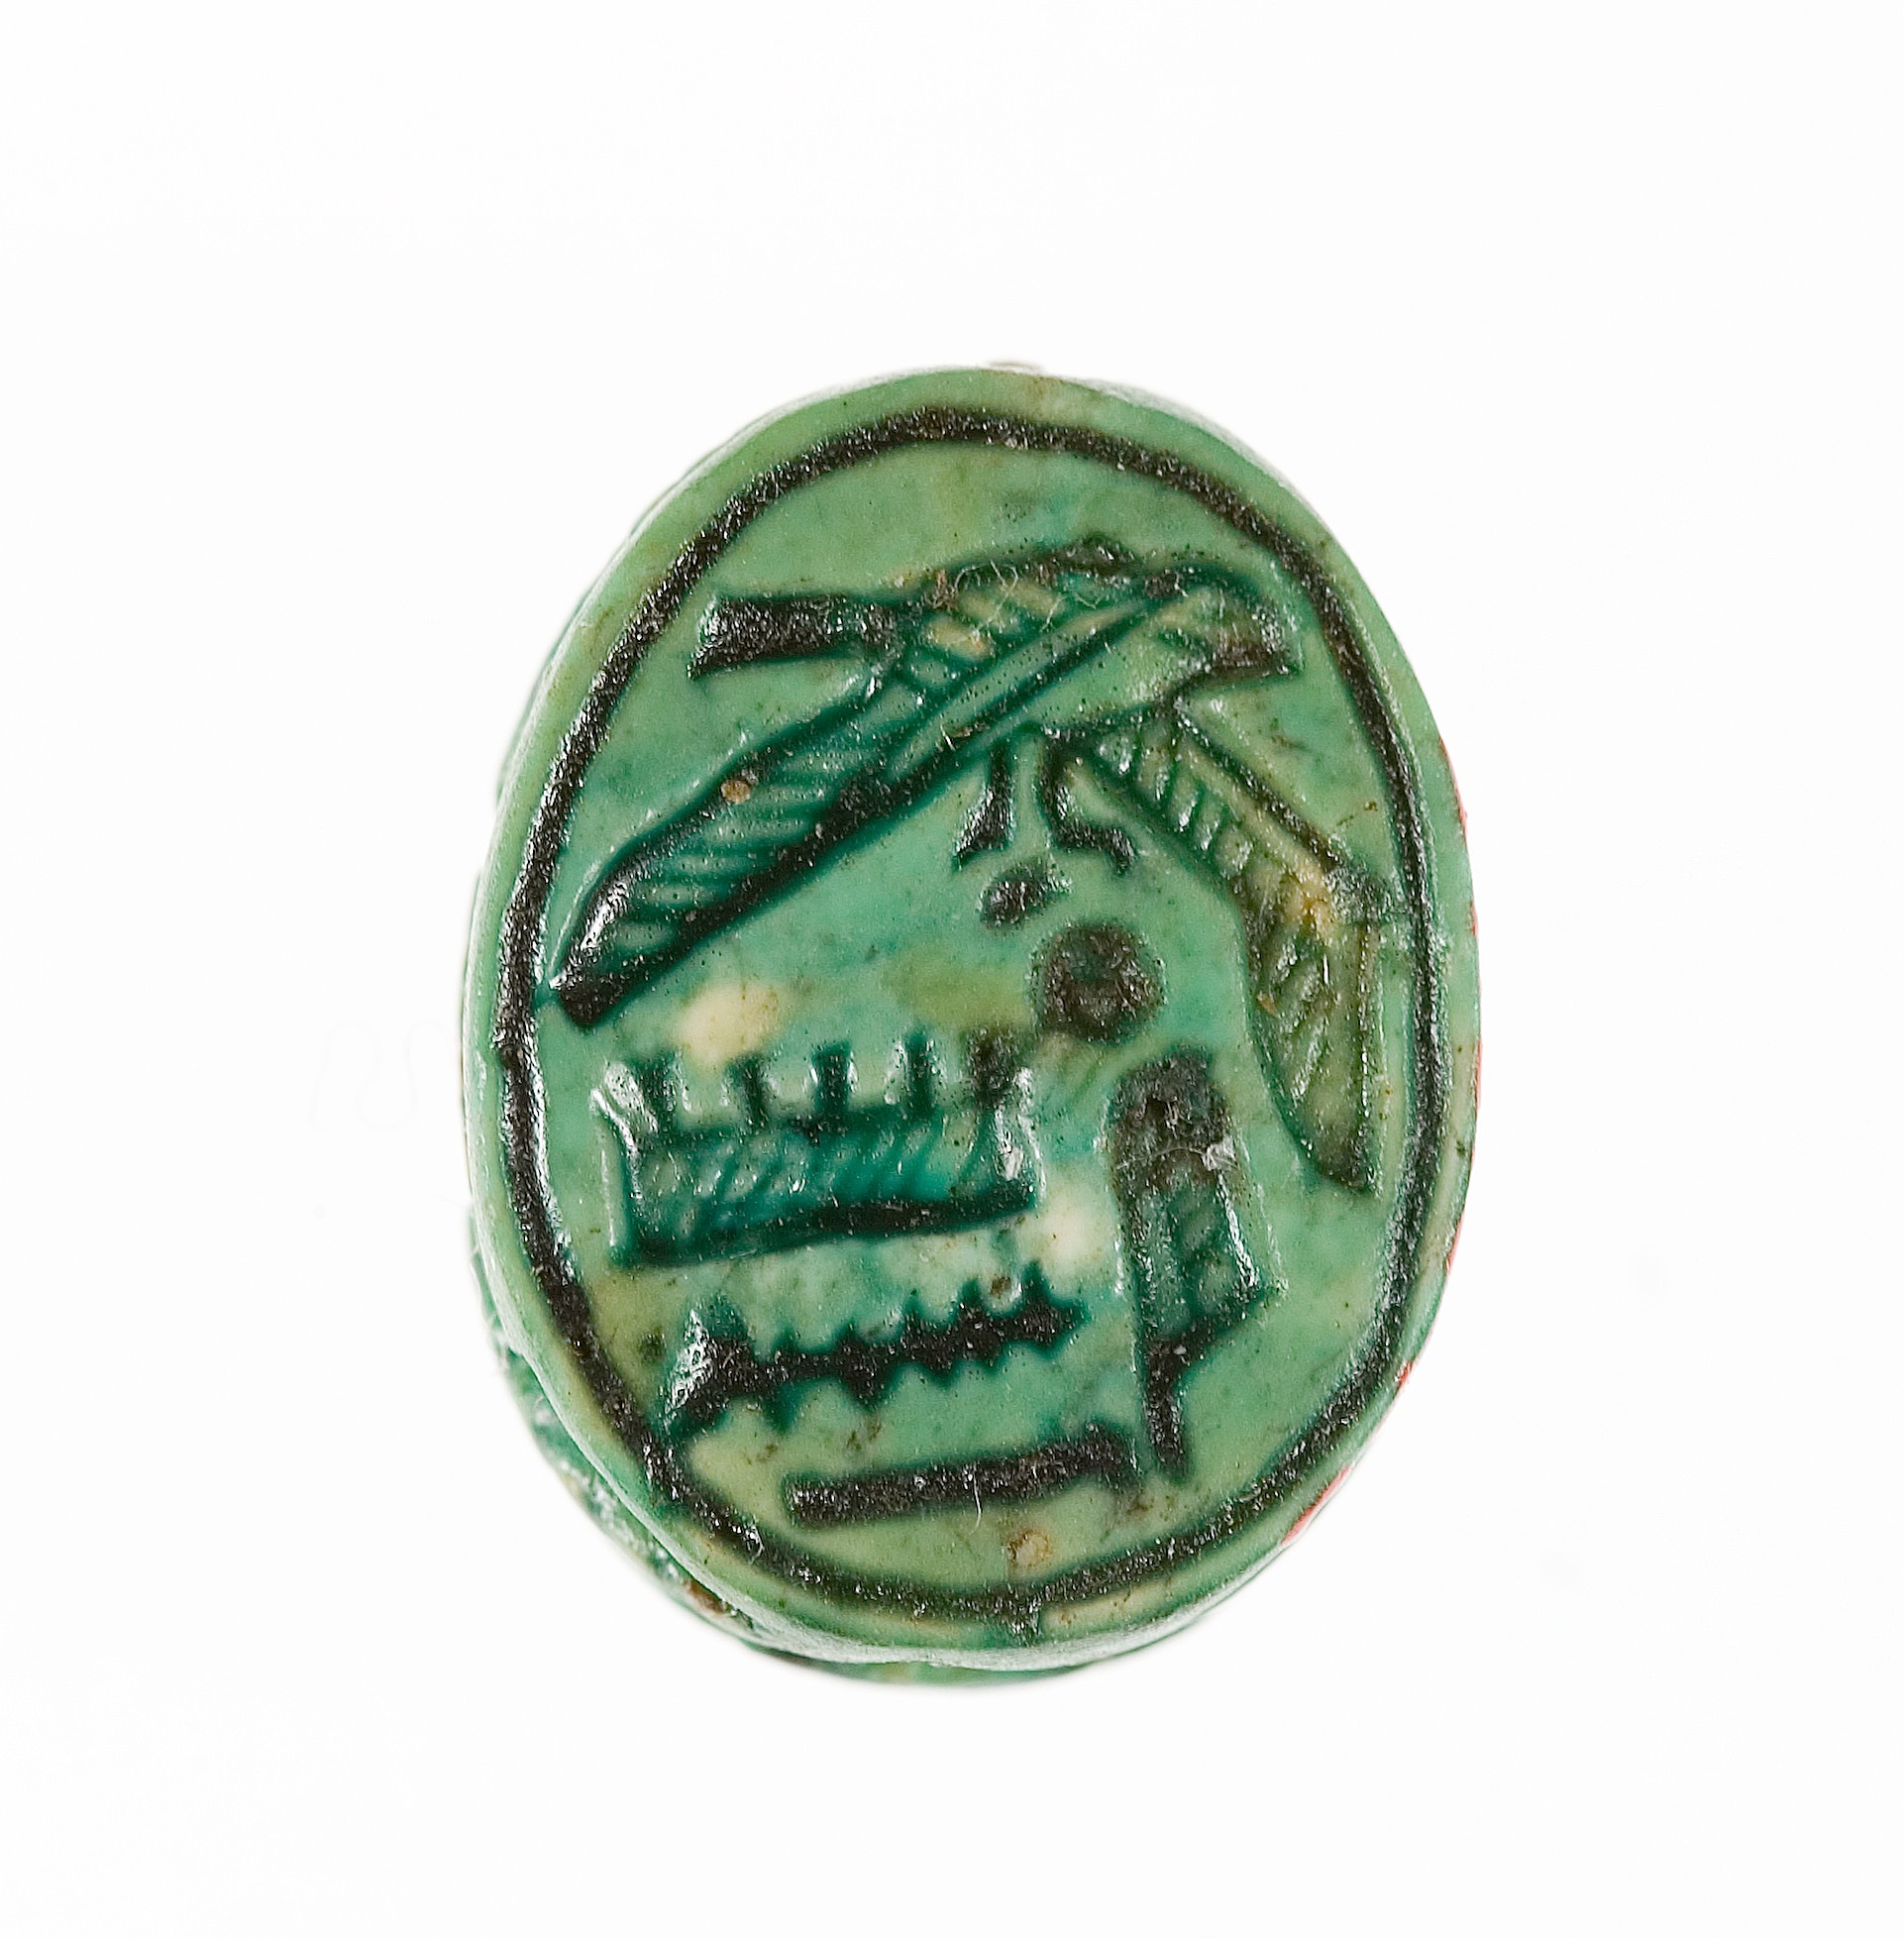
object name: scarab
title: Scarab Inscribed with the Name of the God Amun-Re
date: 1479-1458 BCE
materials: stone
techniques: glazing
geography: egypt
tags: scarabs